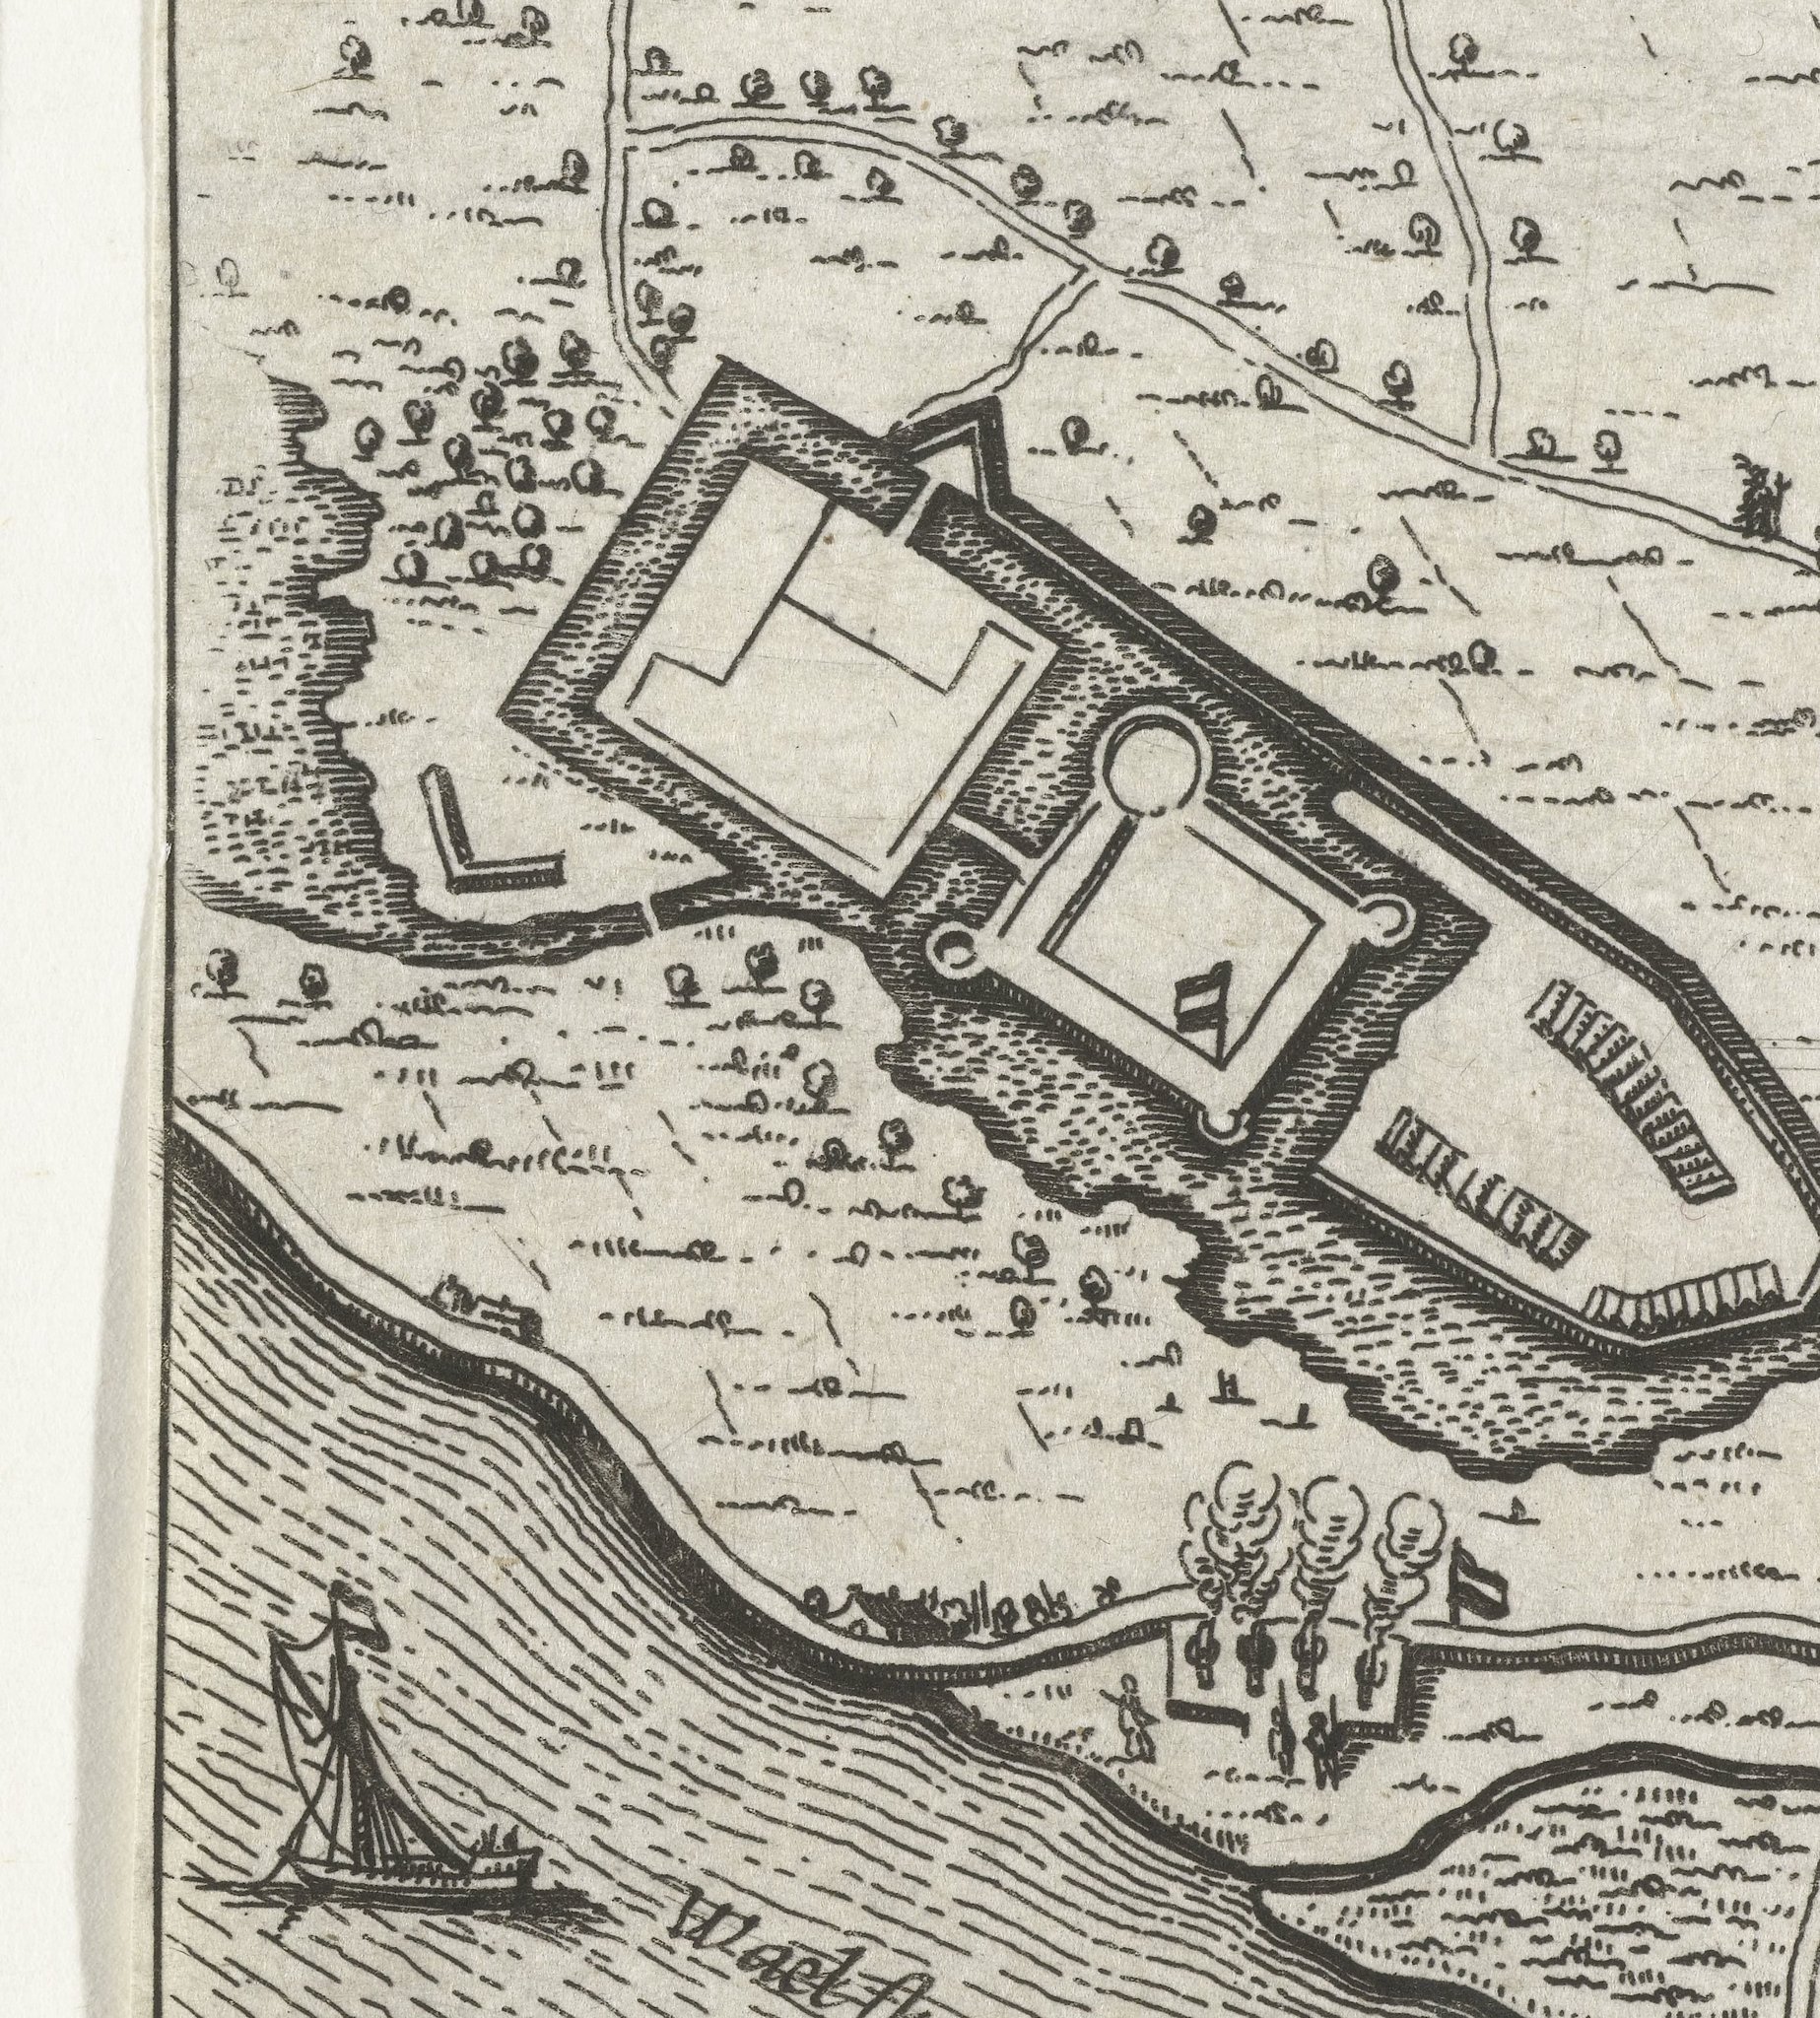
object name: map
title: Plattegrond van Huis Bylandt, 1631-1632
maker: Anonymous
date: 1632-1649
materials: paper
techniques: etching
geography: northern netherlands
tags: maps of cities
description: Plattegrond van Huis Bylandt, vroeger bekend als Huis te Halt. Onderdeel van een groep plattegronden van steden, forten en dijken in Brabant veroverd door het Staatse leger onder Frederik Hendrik in de jaren 1631-1632.